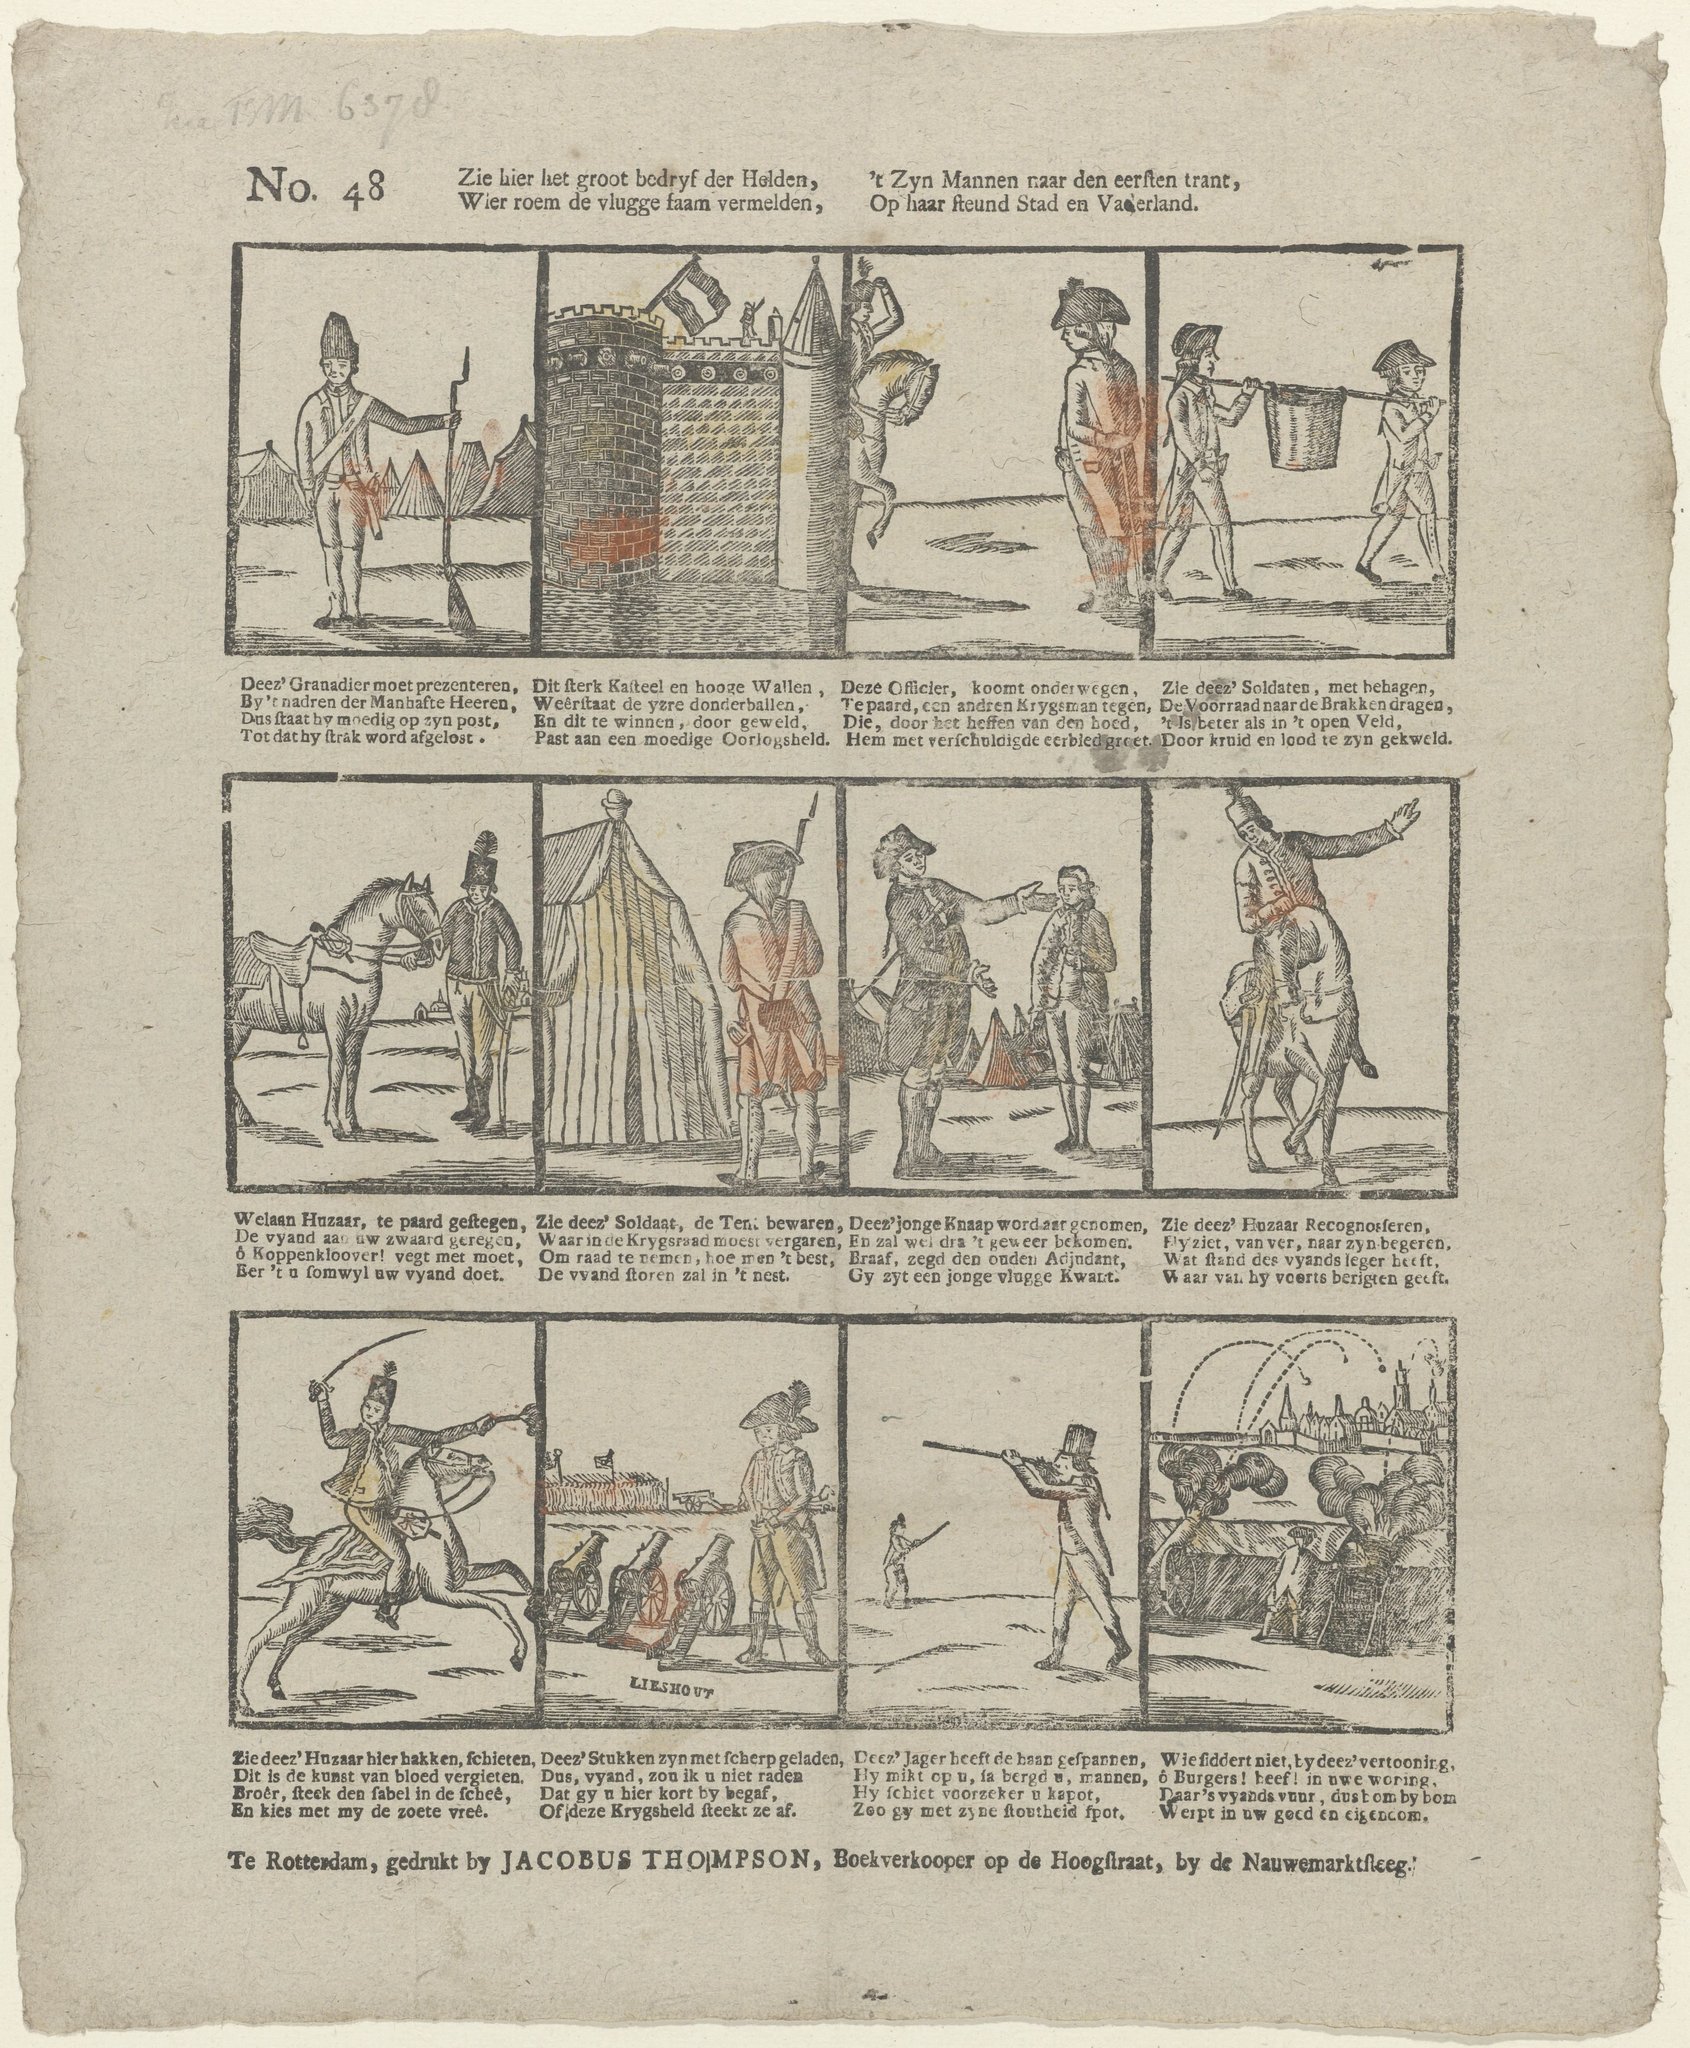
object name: print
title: Zie hier het groot bedryf der helden, / Wier roem de vlugge faam vermelden, / 't zyn mannen naar den eersten trant, / Op haar steund stad en vaderland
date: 1791-1812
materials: paper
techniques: colour, letterpress printing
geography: netherlands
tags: weapons, warfare; military affairs (+ cavalry, horsemen), warfare; military affairs, the soldier; the soldier's life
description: Blad met 12 voorstellingen van militairen. Onder elke afbeelding een vierregelig vers. Genummerd linksboven: No. 48.